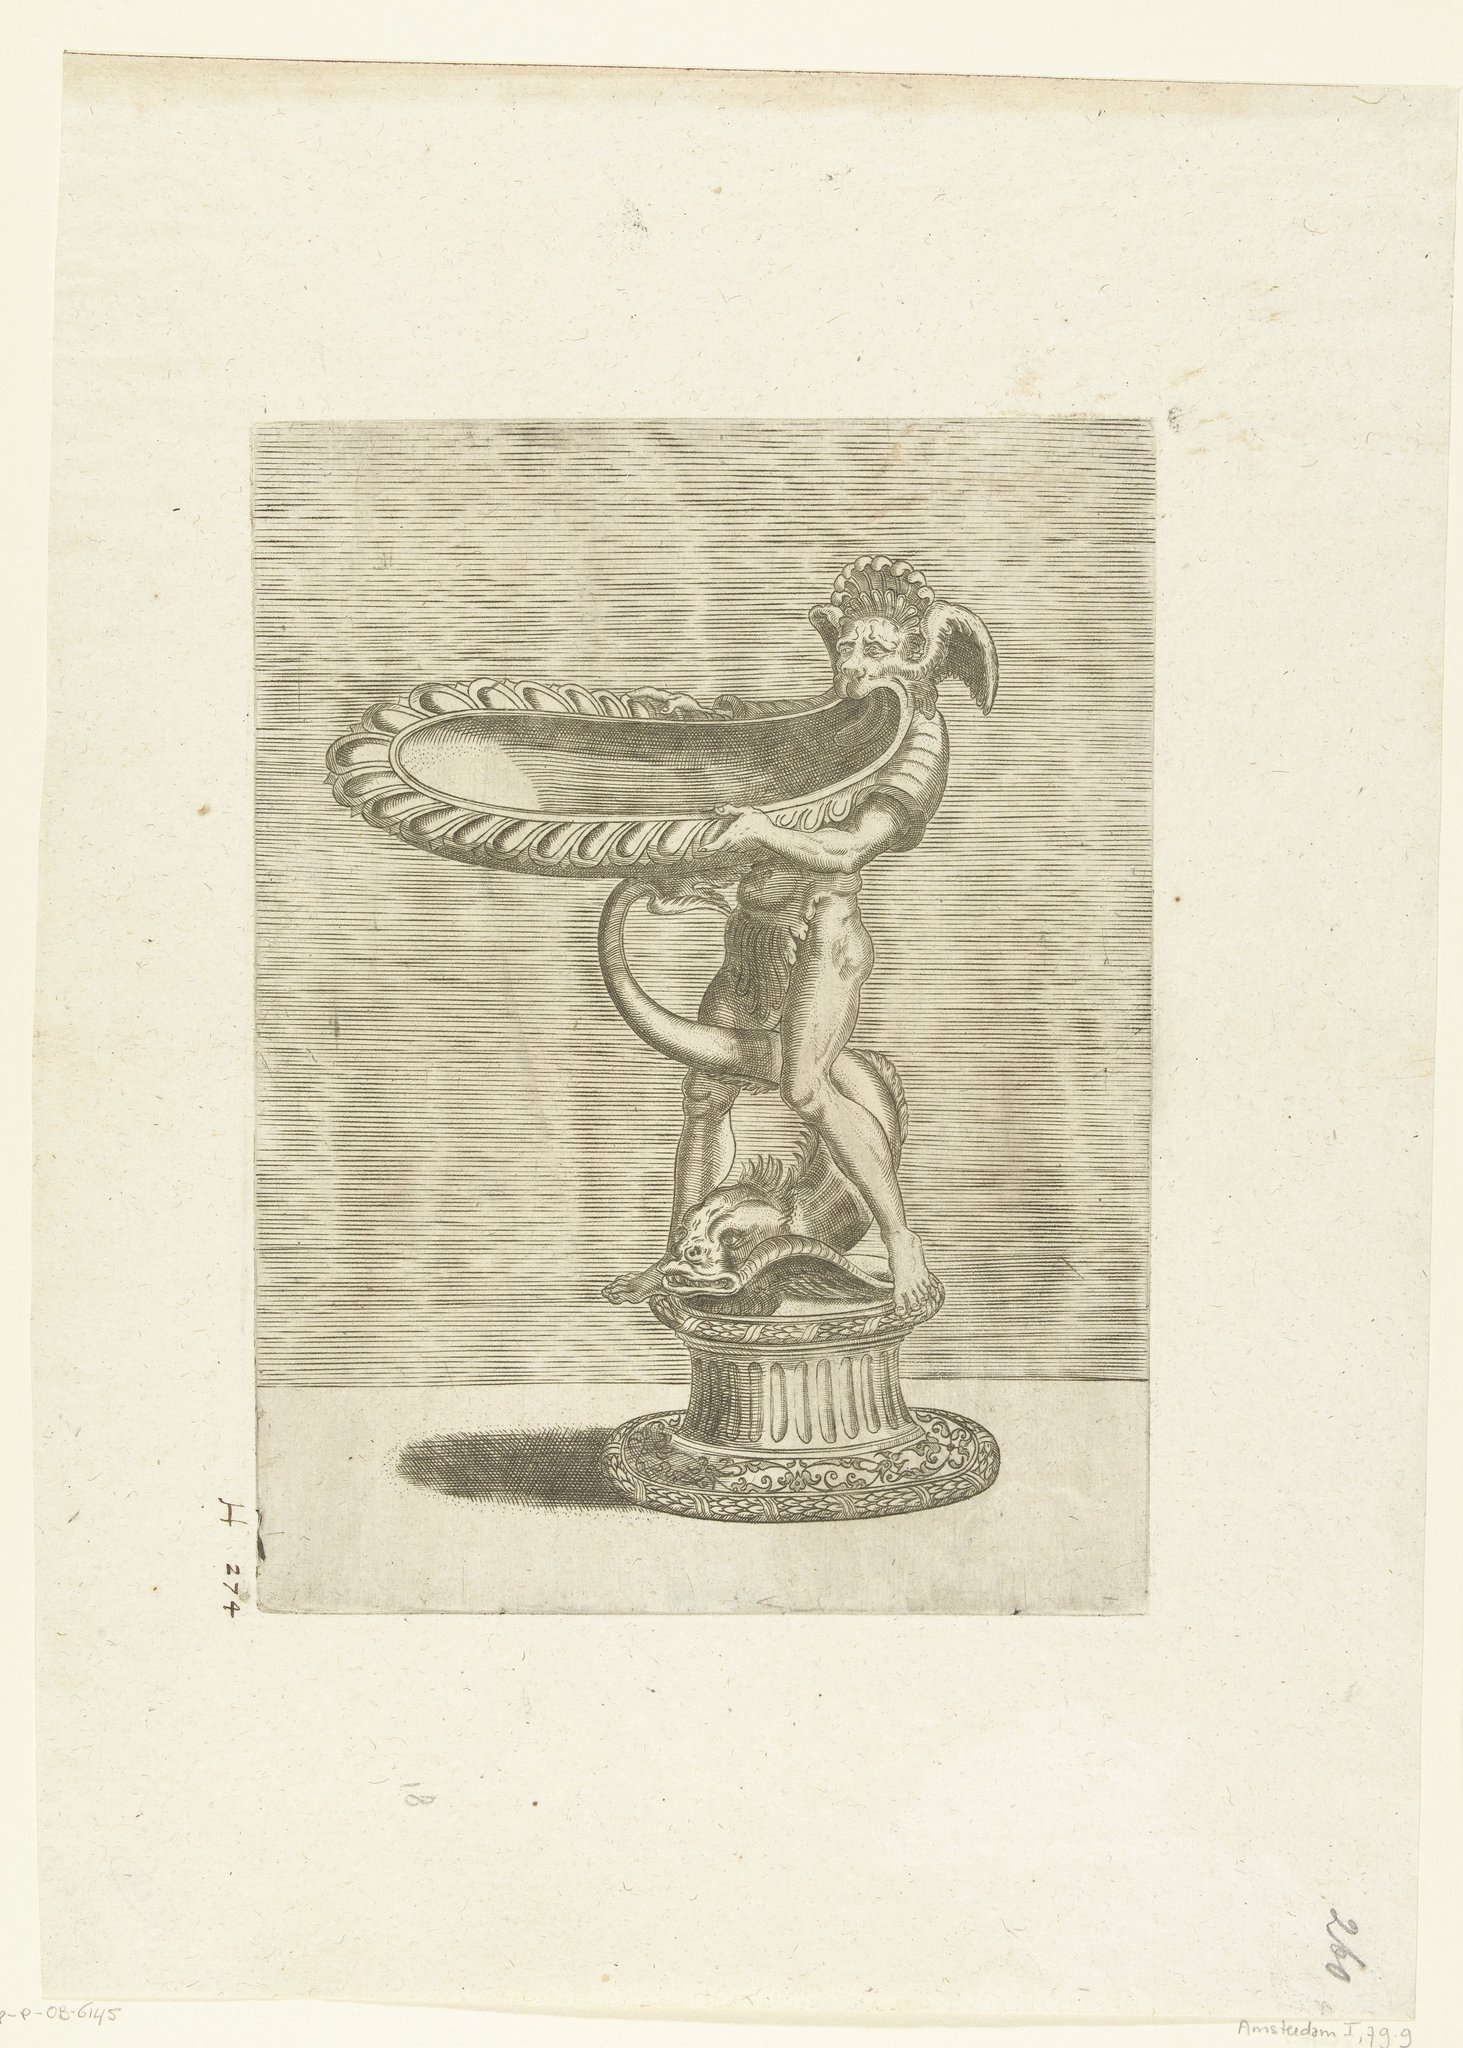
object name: print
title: Vazen, kannen en schalen met grotesken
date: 1548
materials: paper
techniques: engraving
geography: netherlands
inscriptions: number: ‘H. 274’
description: De schaal rust op de staart van een vis die tussen de benen van de man ligt. De man zelf steunt zijn kaak met zijn armen. Afkomstig uit een serie bestaande uit een titelblad en 20 bladen.